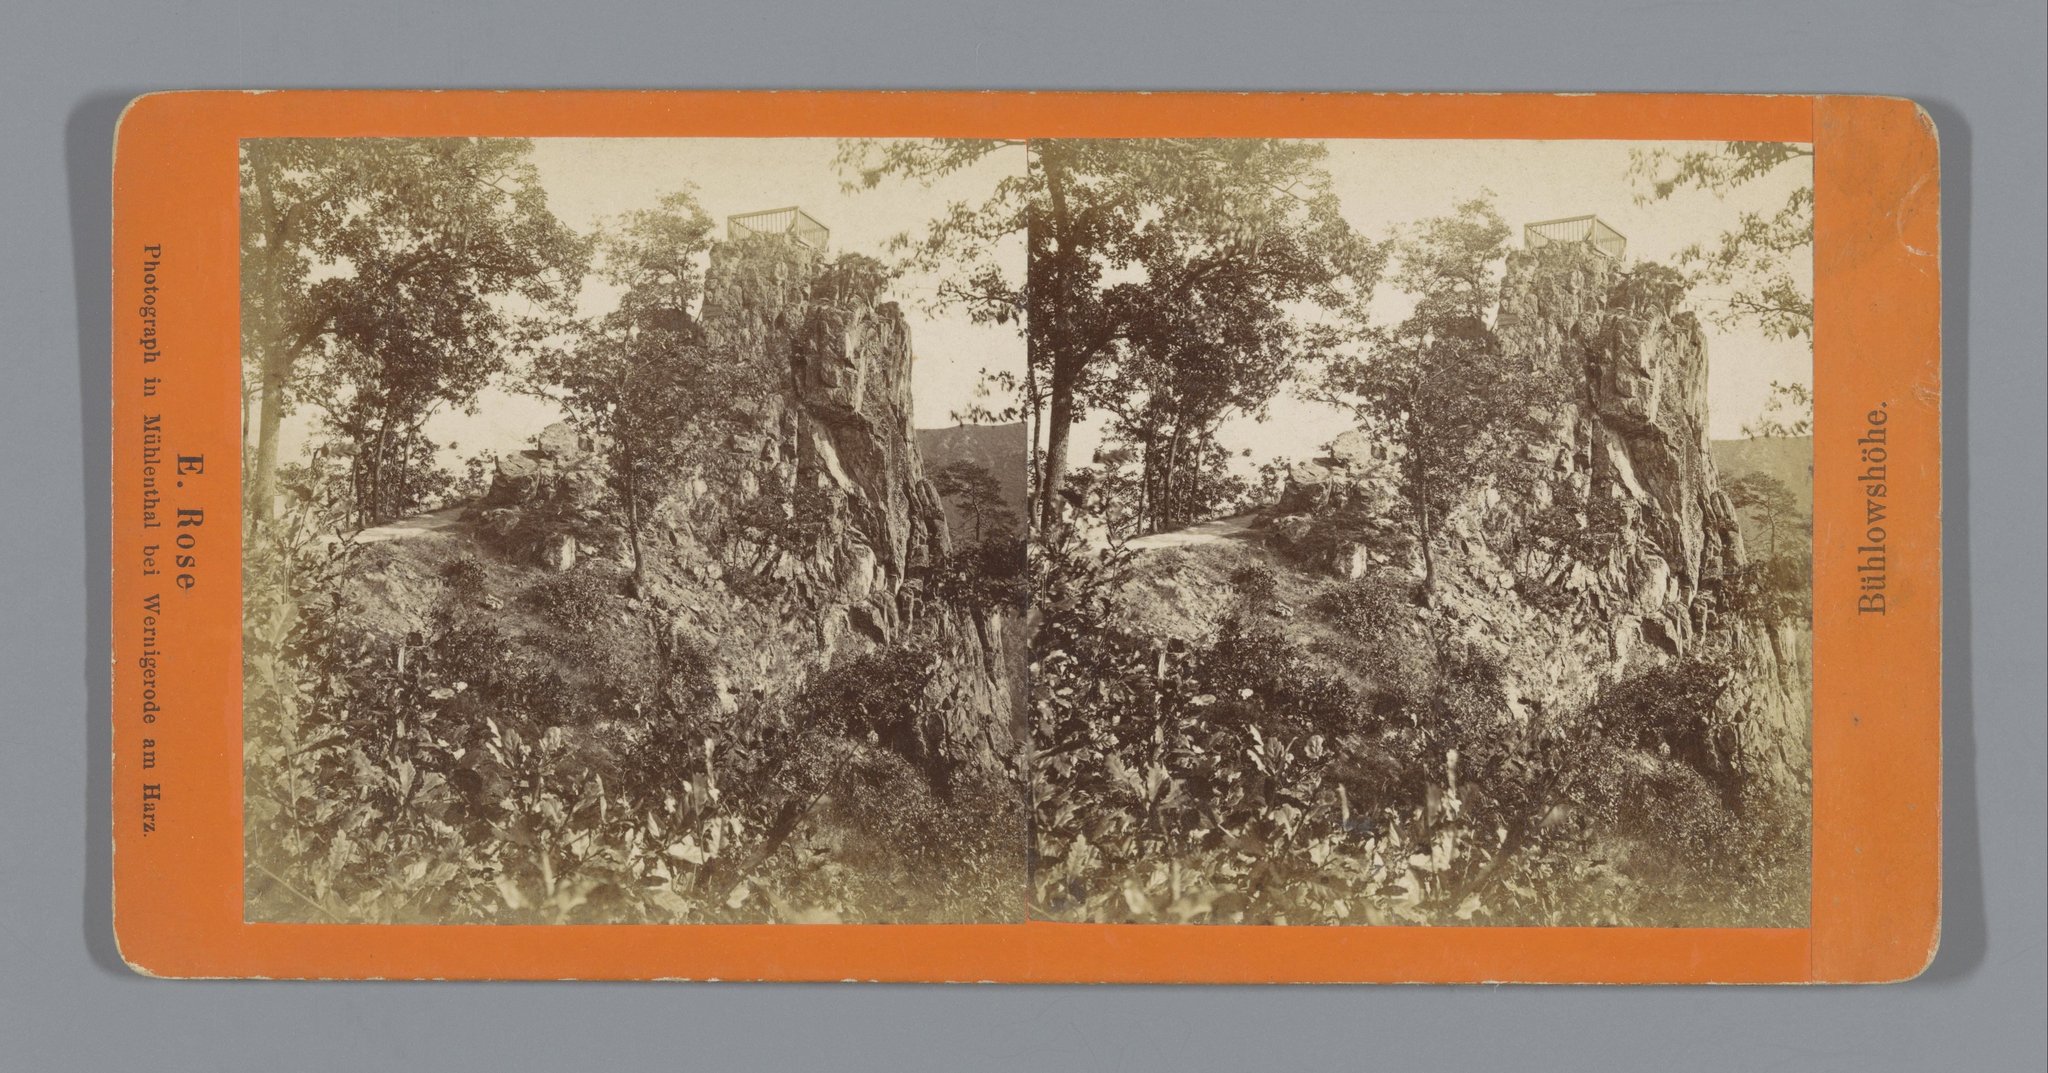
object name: stereograph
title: Bülowshöhe te Harz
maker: e. rose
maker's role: fotograaf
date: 1855-1880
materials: cardboard, photographic support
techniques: albumen print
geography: harz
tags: rock-formations, mountains